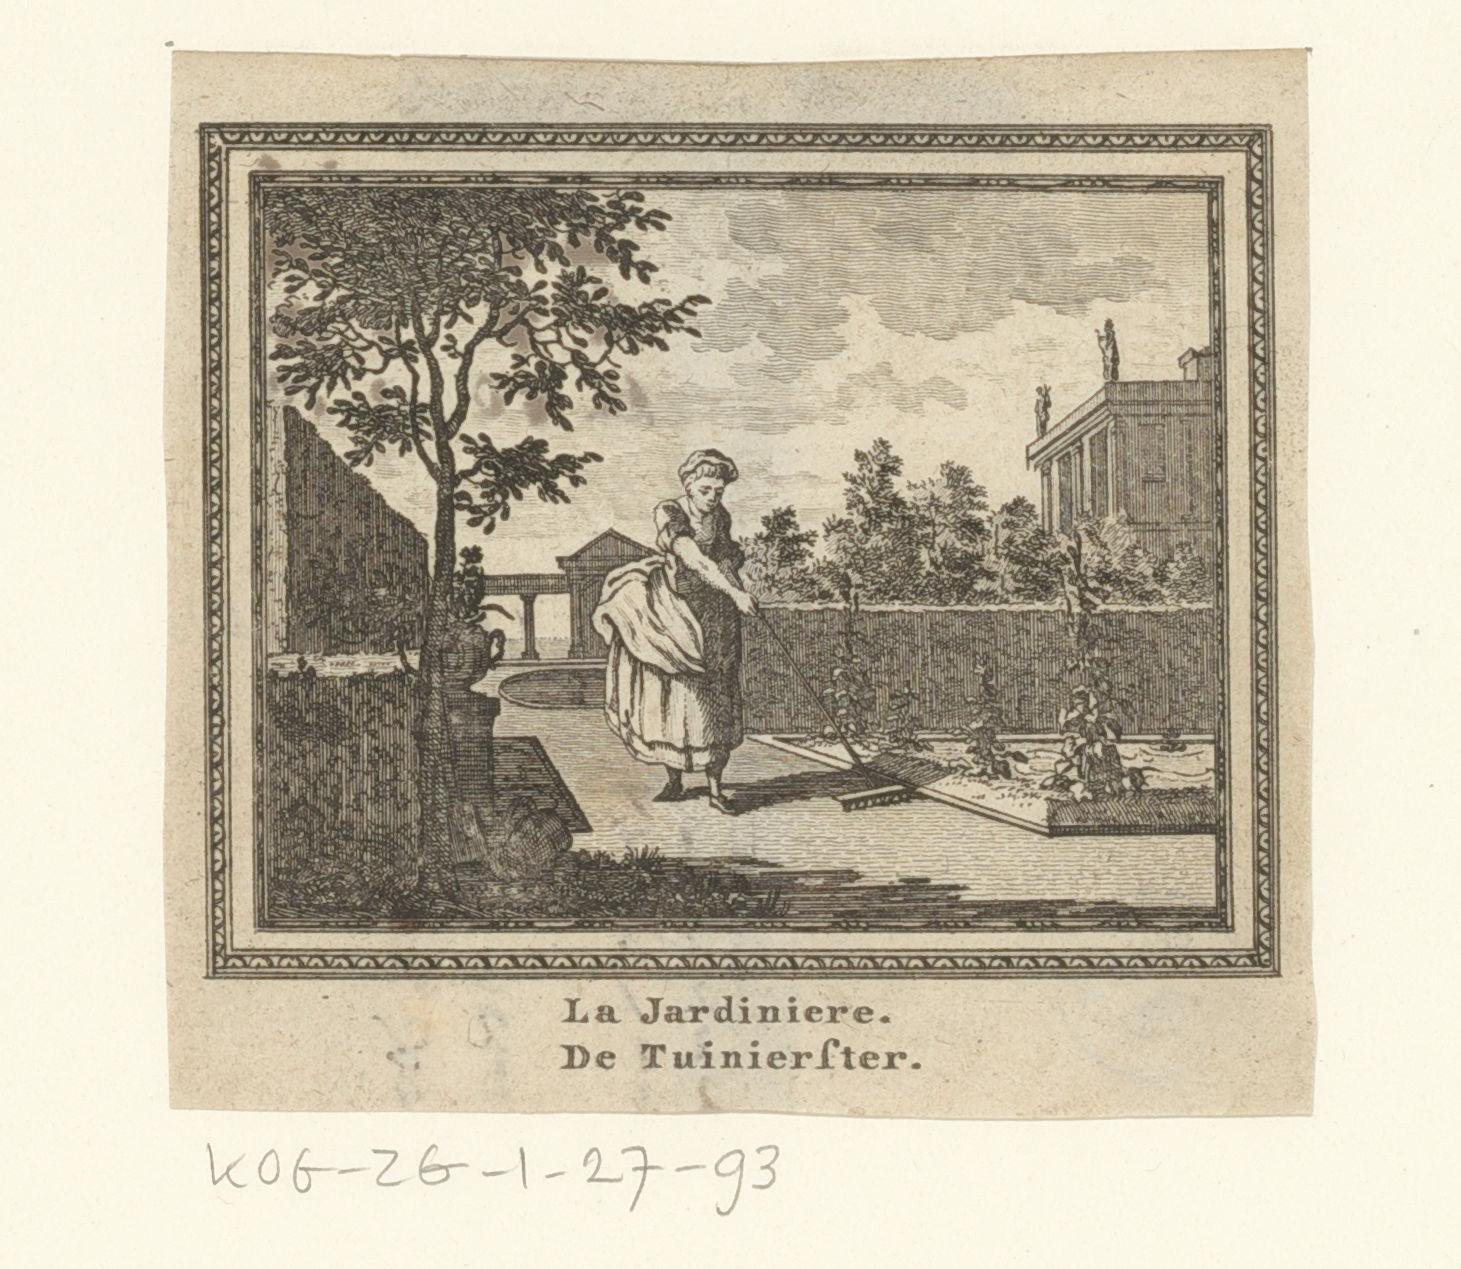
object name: print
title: La Jardiniere / De Tuinierster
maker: Anonymous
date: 1700-1799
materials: paper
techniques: etching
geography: netherlands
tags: garden, gardening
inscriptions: collector's mark: Lugt 1641, collector's mark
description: Prent mogelijk uit: Willink, Daniël. Daniël Willinks Amsterdamsche Buitensingel Nevens de omleggende dorpen, opgeheldert door aanteekeningen (…). Amsterdam: Andries van Damme, 1723. Of uit: Willink, Daniël. Daniël Willinks Amsterdamsche Buitensingel, Nevens de omleggende dorpen, opgeheldert door aanteekeningen (…). Amsterdam: Arend van Huyssteen, 1738.